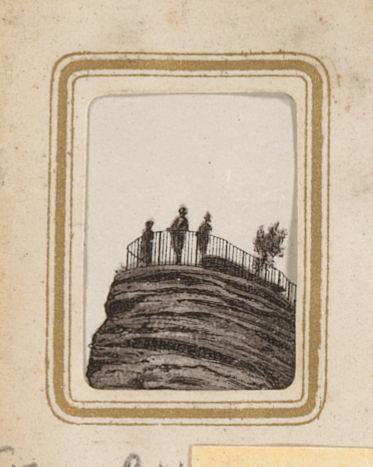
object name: print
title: Uitkijkpunt op de Pravčická brána in Boheems Zwitserland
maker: Anonymous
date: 1851-1910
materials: paper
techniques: lithograph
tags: mountains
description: Deze prent maakt deel uit van een album.